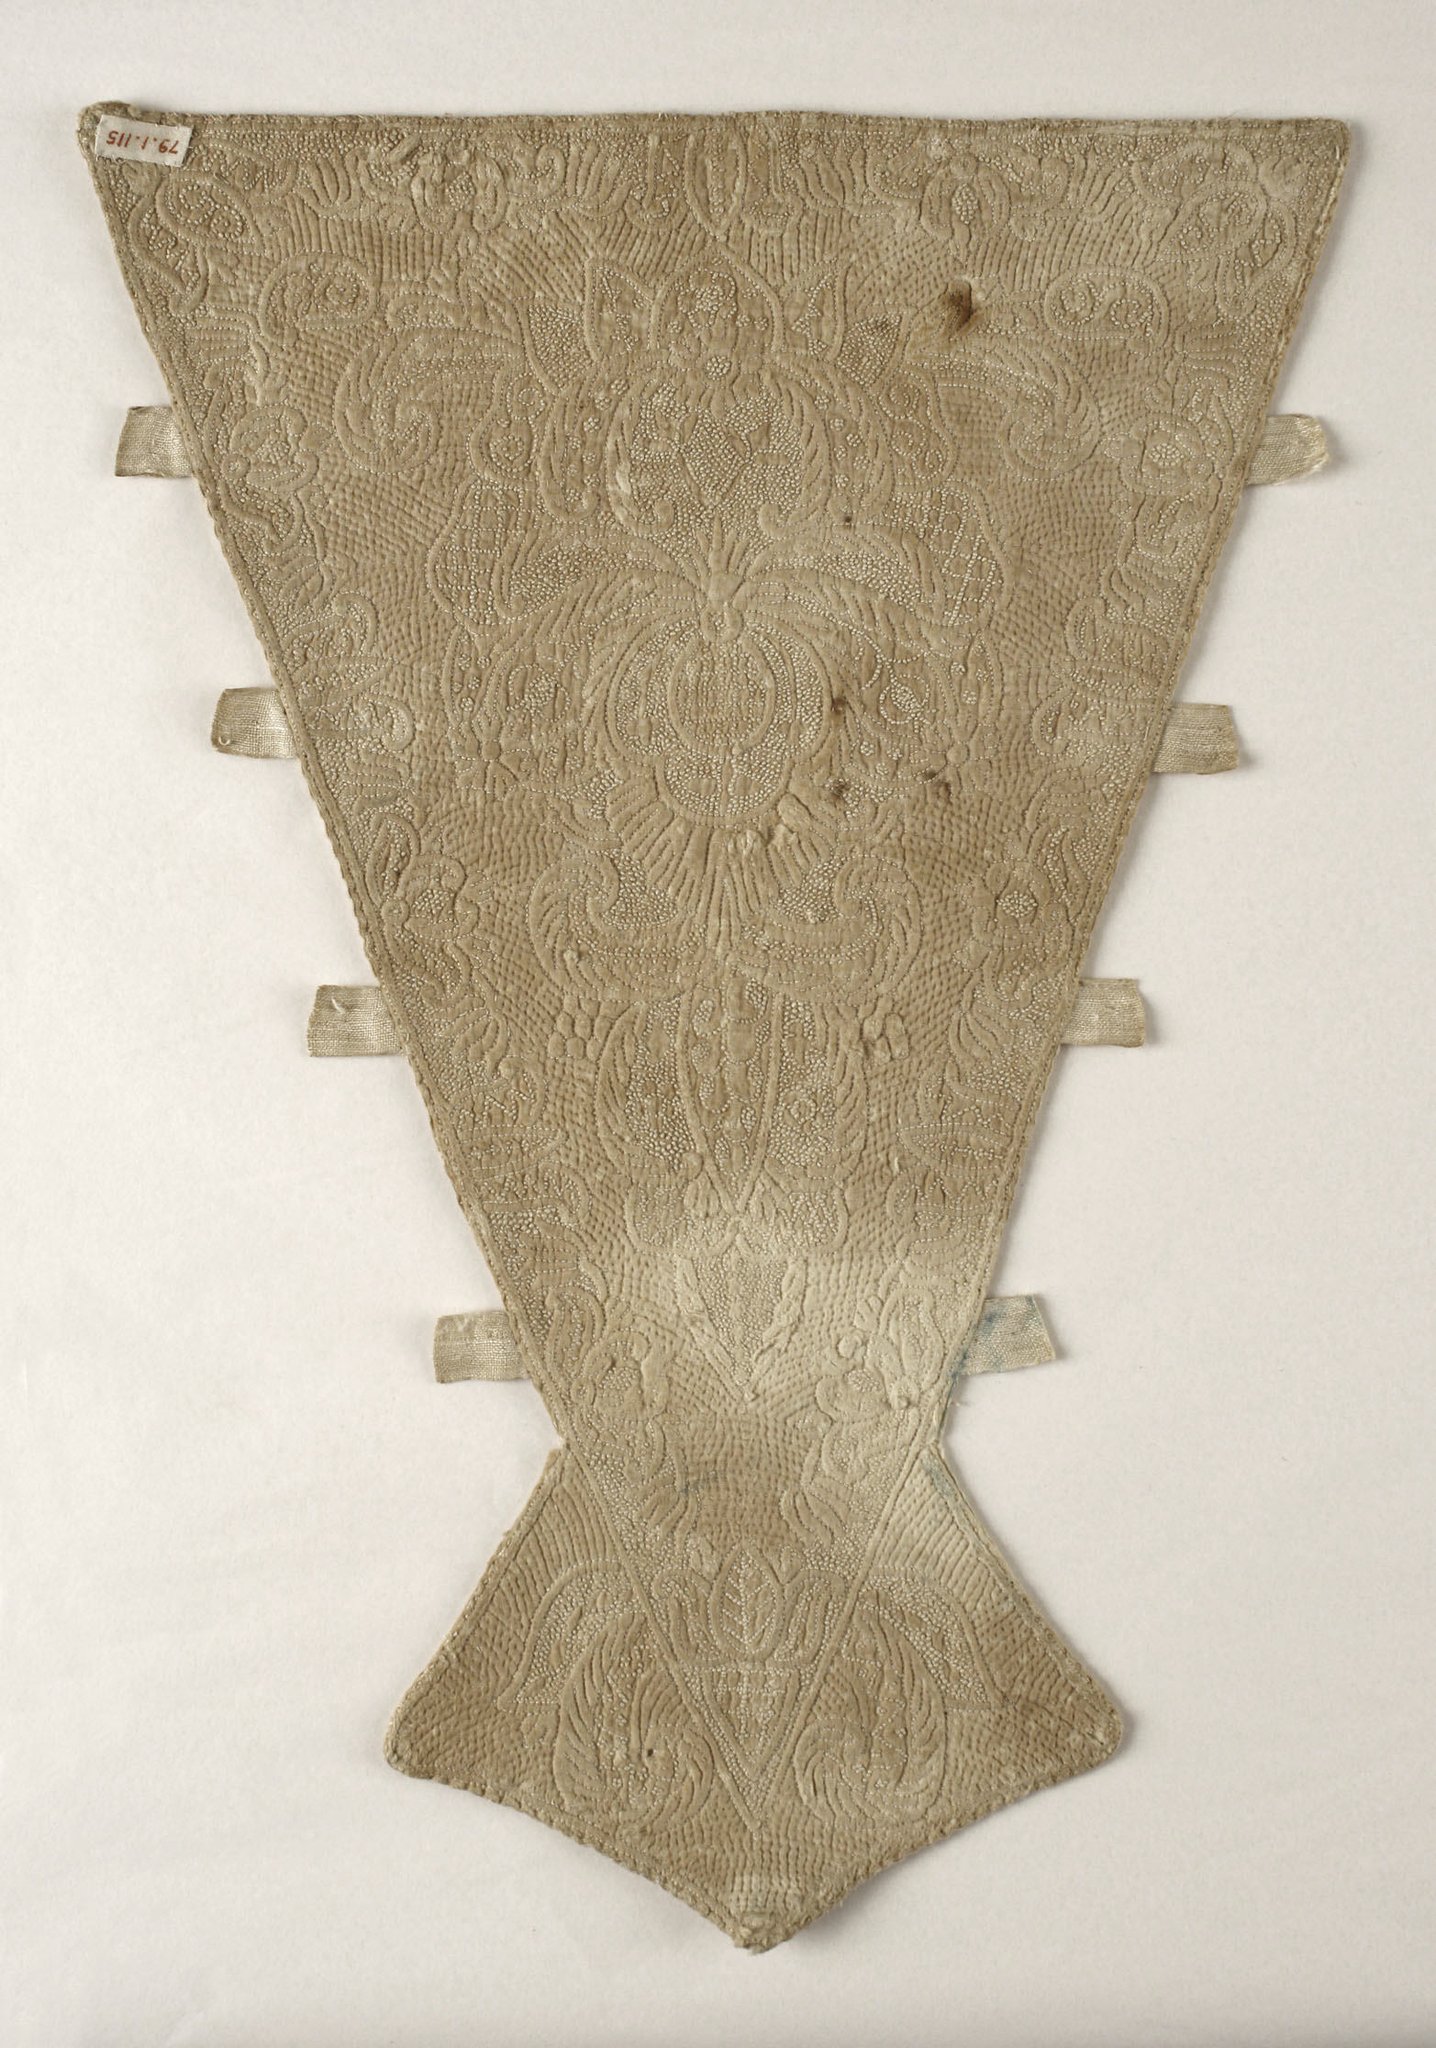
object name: stomacher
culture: european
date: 1701-1733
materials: cotton, linen